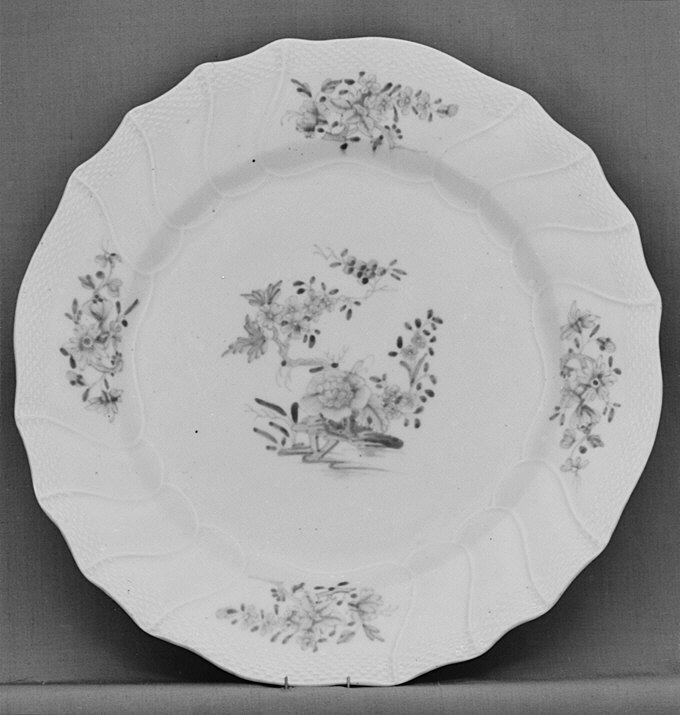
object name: plate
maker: tournai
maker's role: factory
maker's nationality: belgian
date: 1770-1775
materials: soft paste porcelain